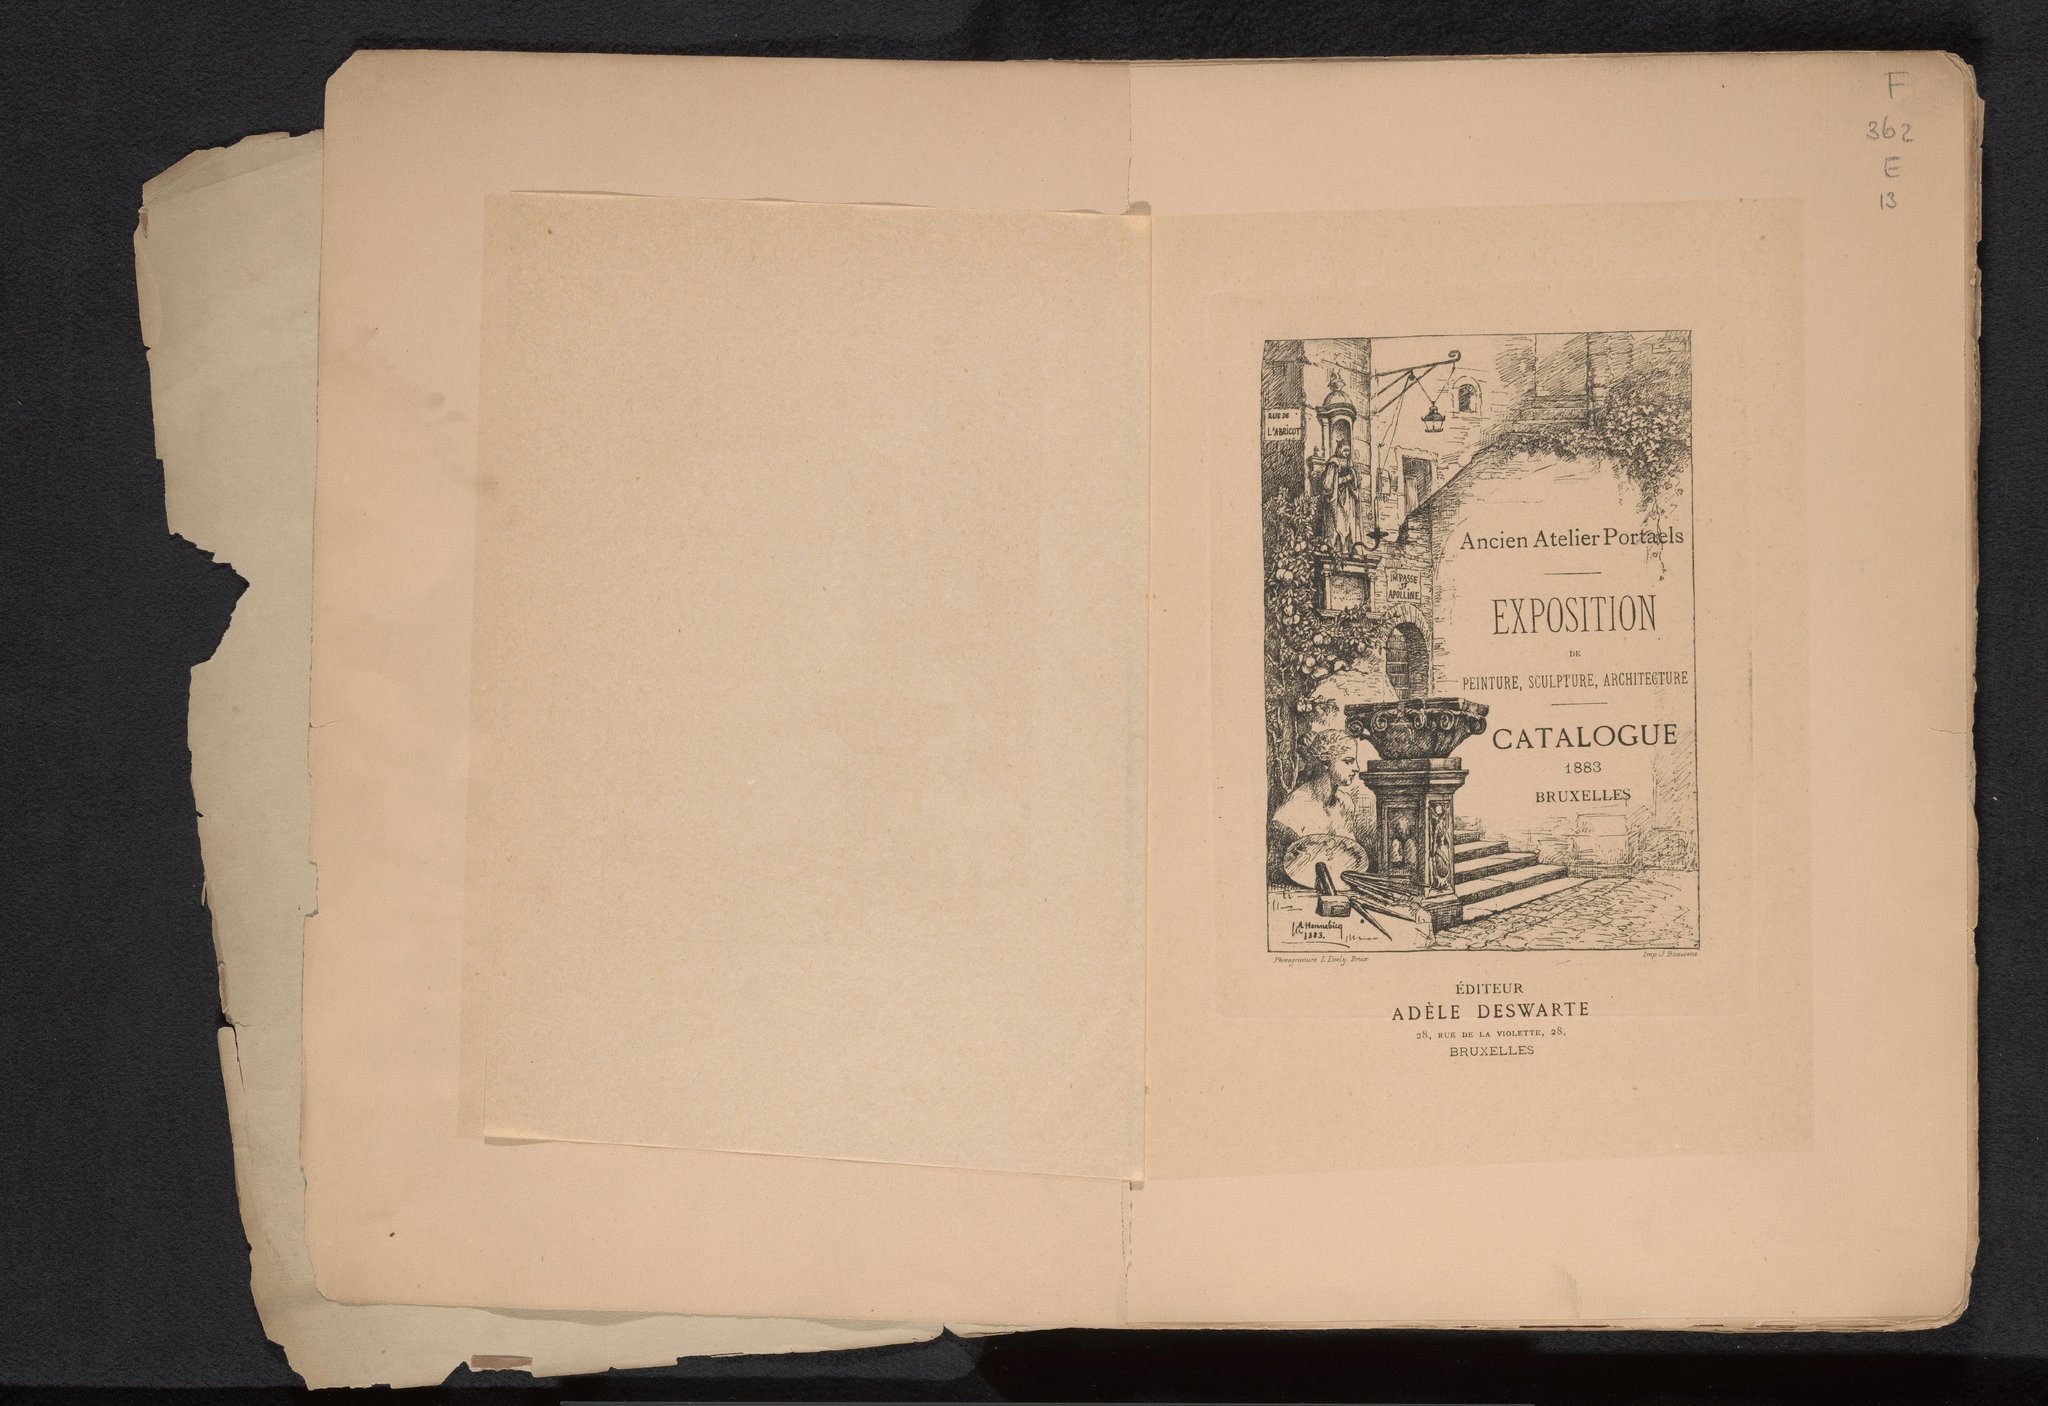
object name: page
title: Reproductie van een tekening van een straathoek door André Hennebicq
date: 1883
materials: paper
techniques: photoaquatint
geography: brussels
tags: torso - aa - female human figure, street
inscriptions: inscription: ‘ÉDITEUR/ ADÈLE DESWARTE/ 28, RUE DE LA VIOLETTE, 28,/ BRUXELLES’, inscription: ‘Ancien Atelier Portaels/ EXPOSITION/ DE/ PEINTURE, SCULTPURE, ARCHITECTURE/ CATALOGUE/ 1883/ BRUXELLES’